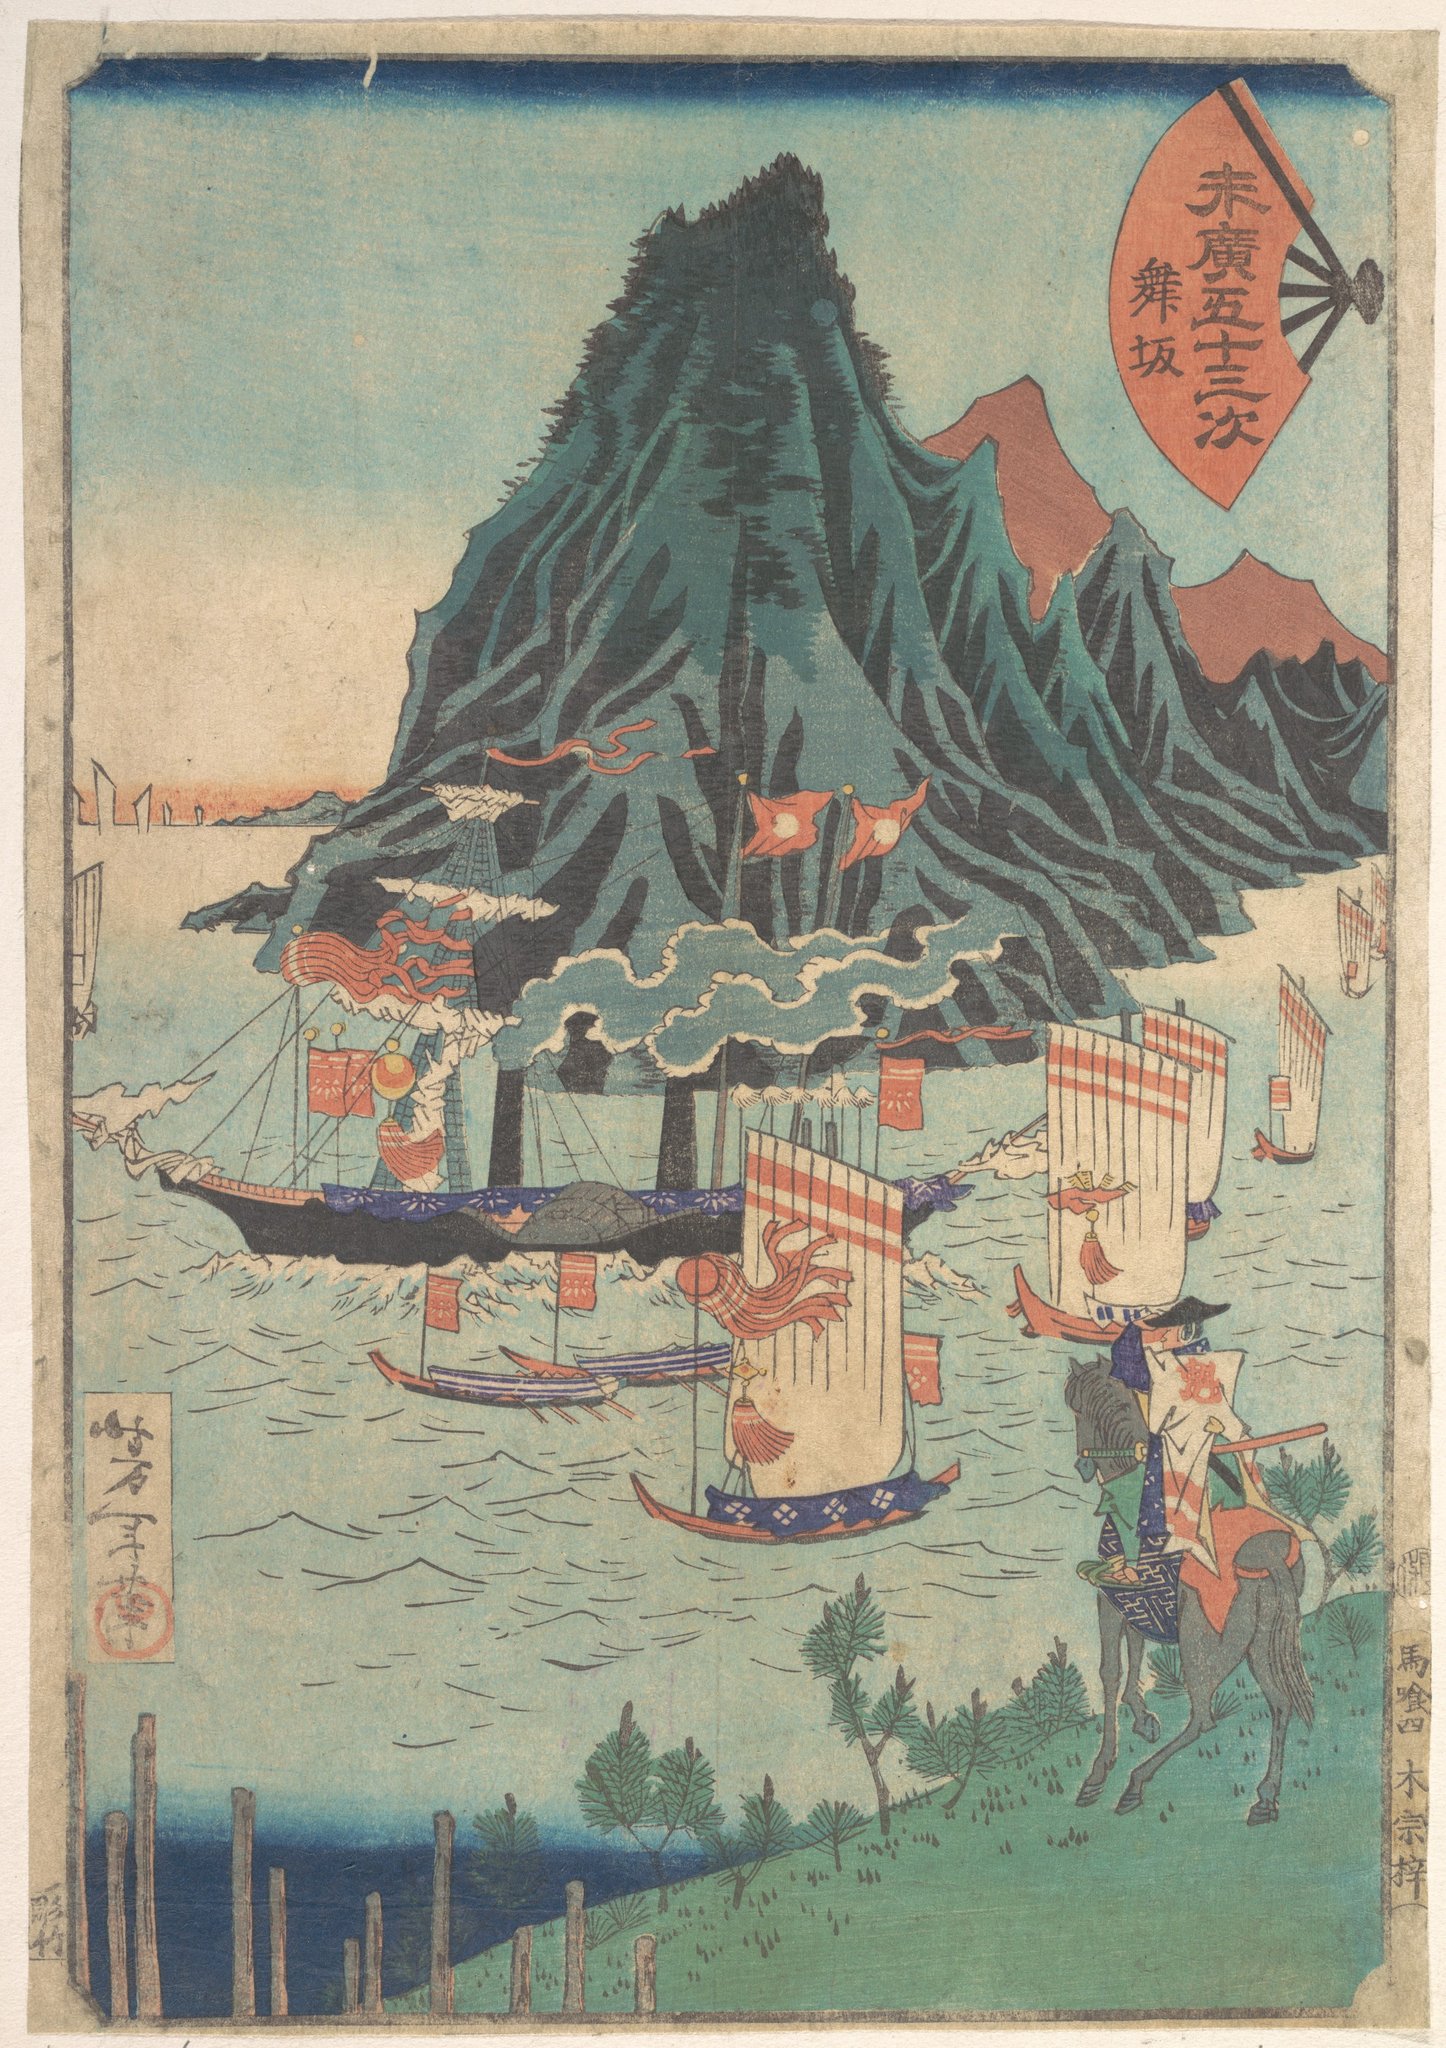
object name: woodblock print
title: Fifty-three Stations of Suehiro: Warrior Looks at Passing Steamship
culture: japanese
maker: tsukioka yoshitoshi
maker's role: artist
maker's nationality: japanese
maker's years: 1839-1892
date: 1865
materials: ink, paper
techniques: woodblock print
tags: men,horses,mountains,boats,ships